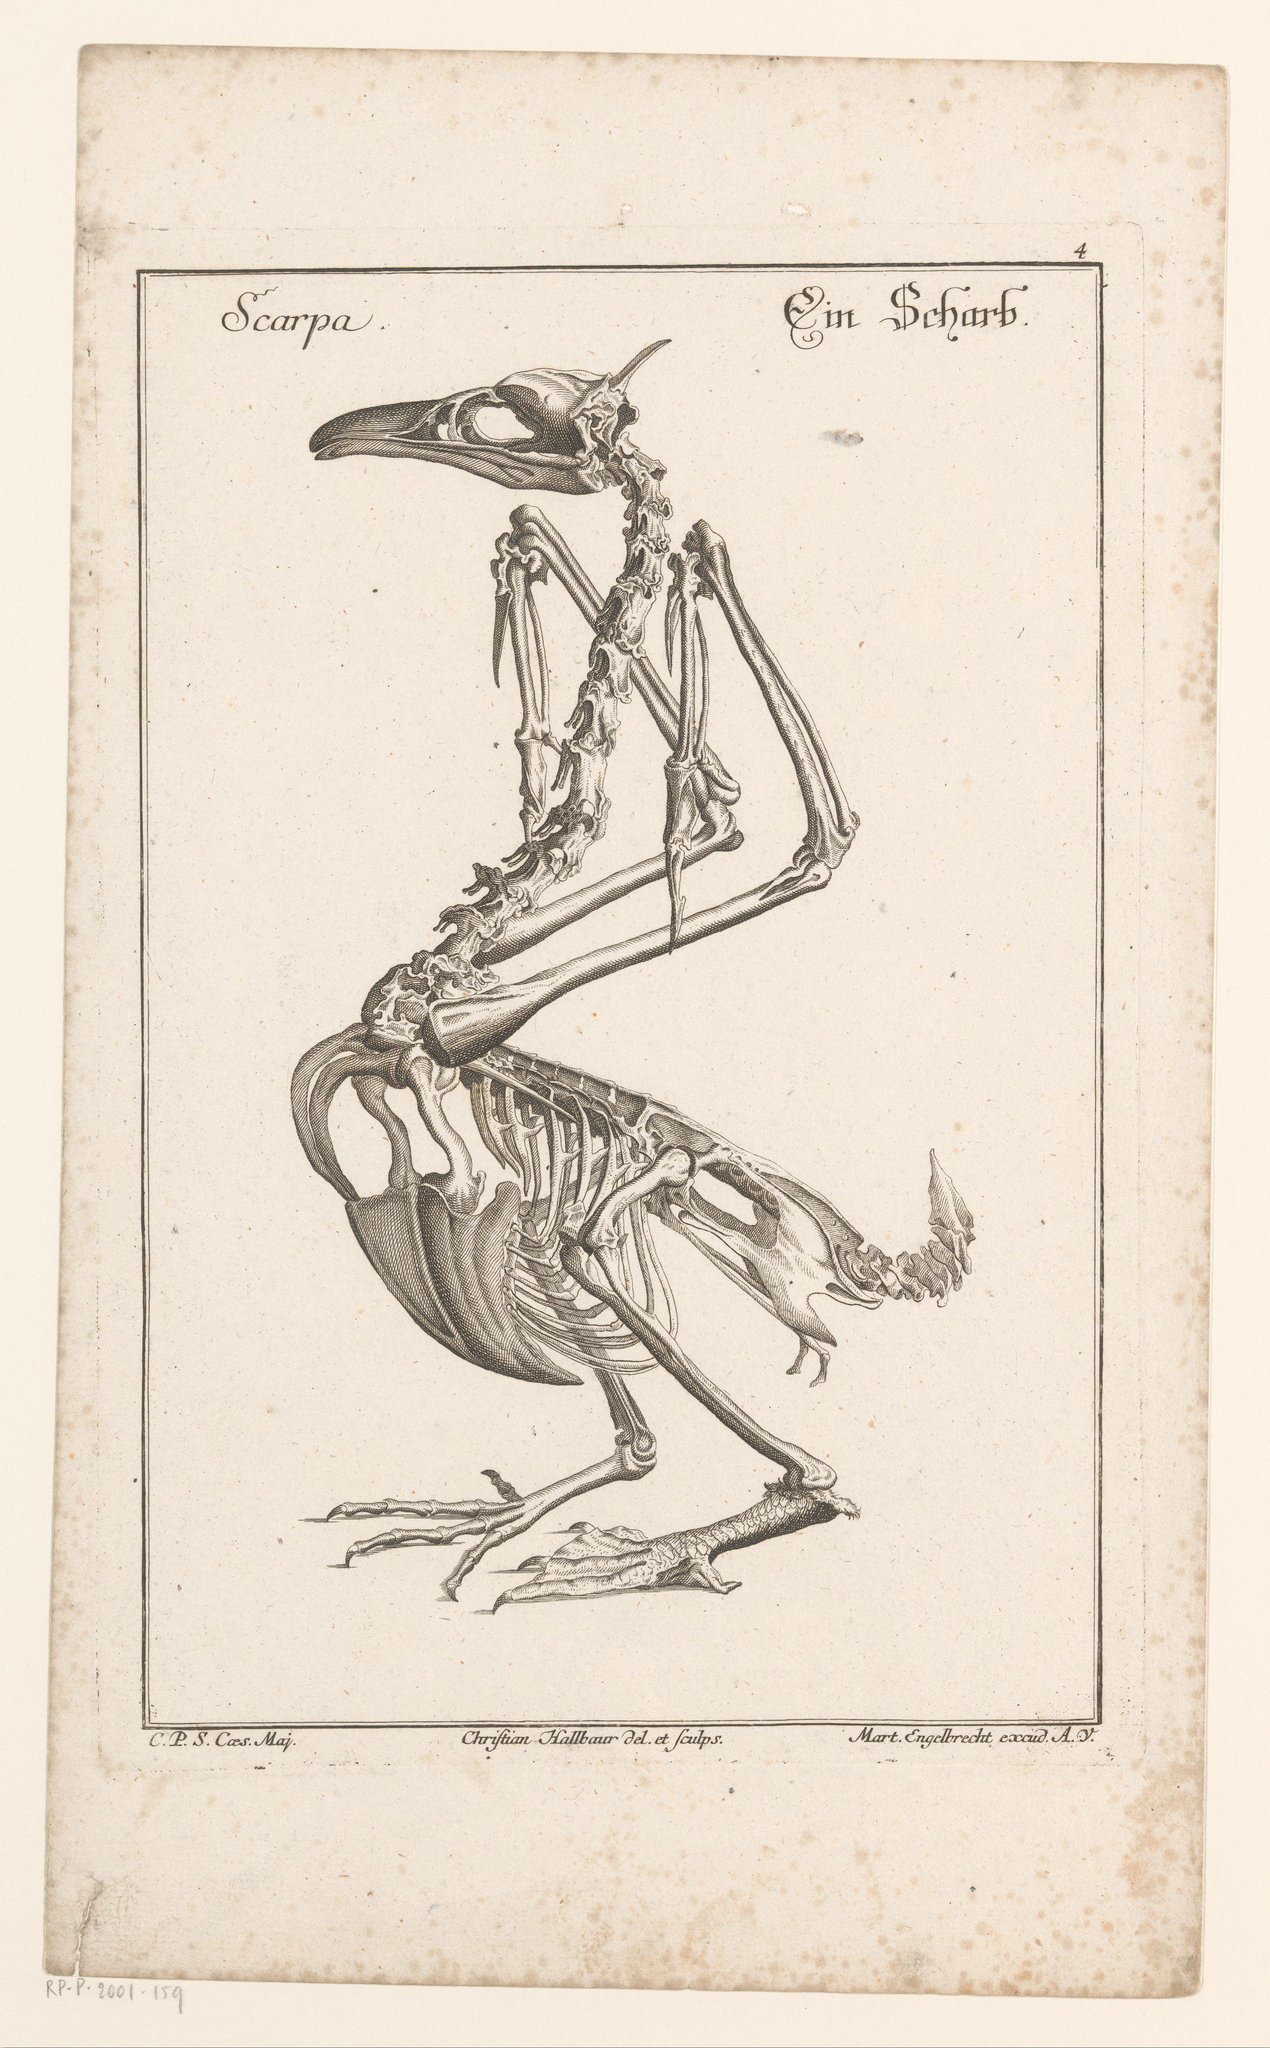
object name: print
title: Scarpa / Ein Scharb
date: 1735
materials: paper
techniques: etching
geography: augsburg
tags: water-birds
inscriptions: collector's mark: Lugt 2228, collector's mark: Lugt 2760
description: Prent gebruikt voor: Hallbaur, Christian. Unterschiedliche Sceleta oder Bein-Cörper. Augsburg: s.n., 1735.